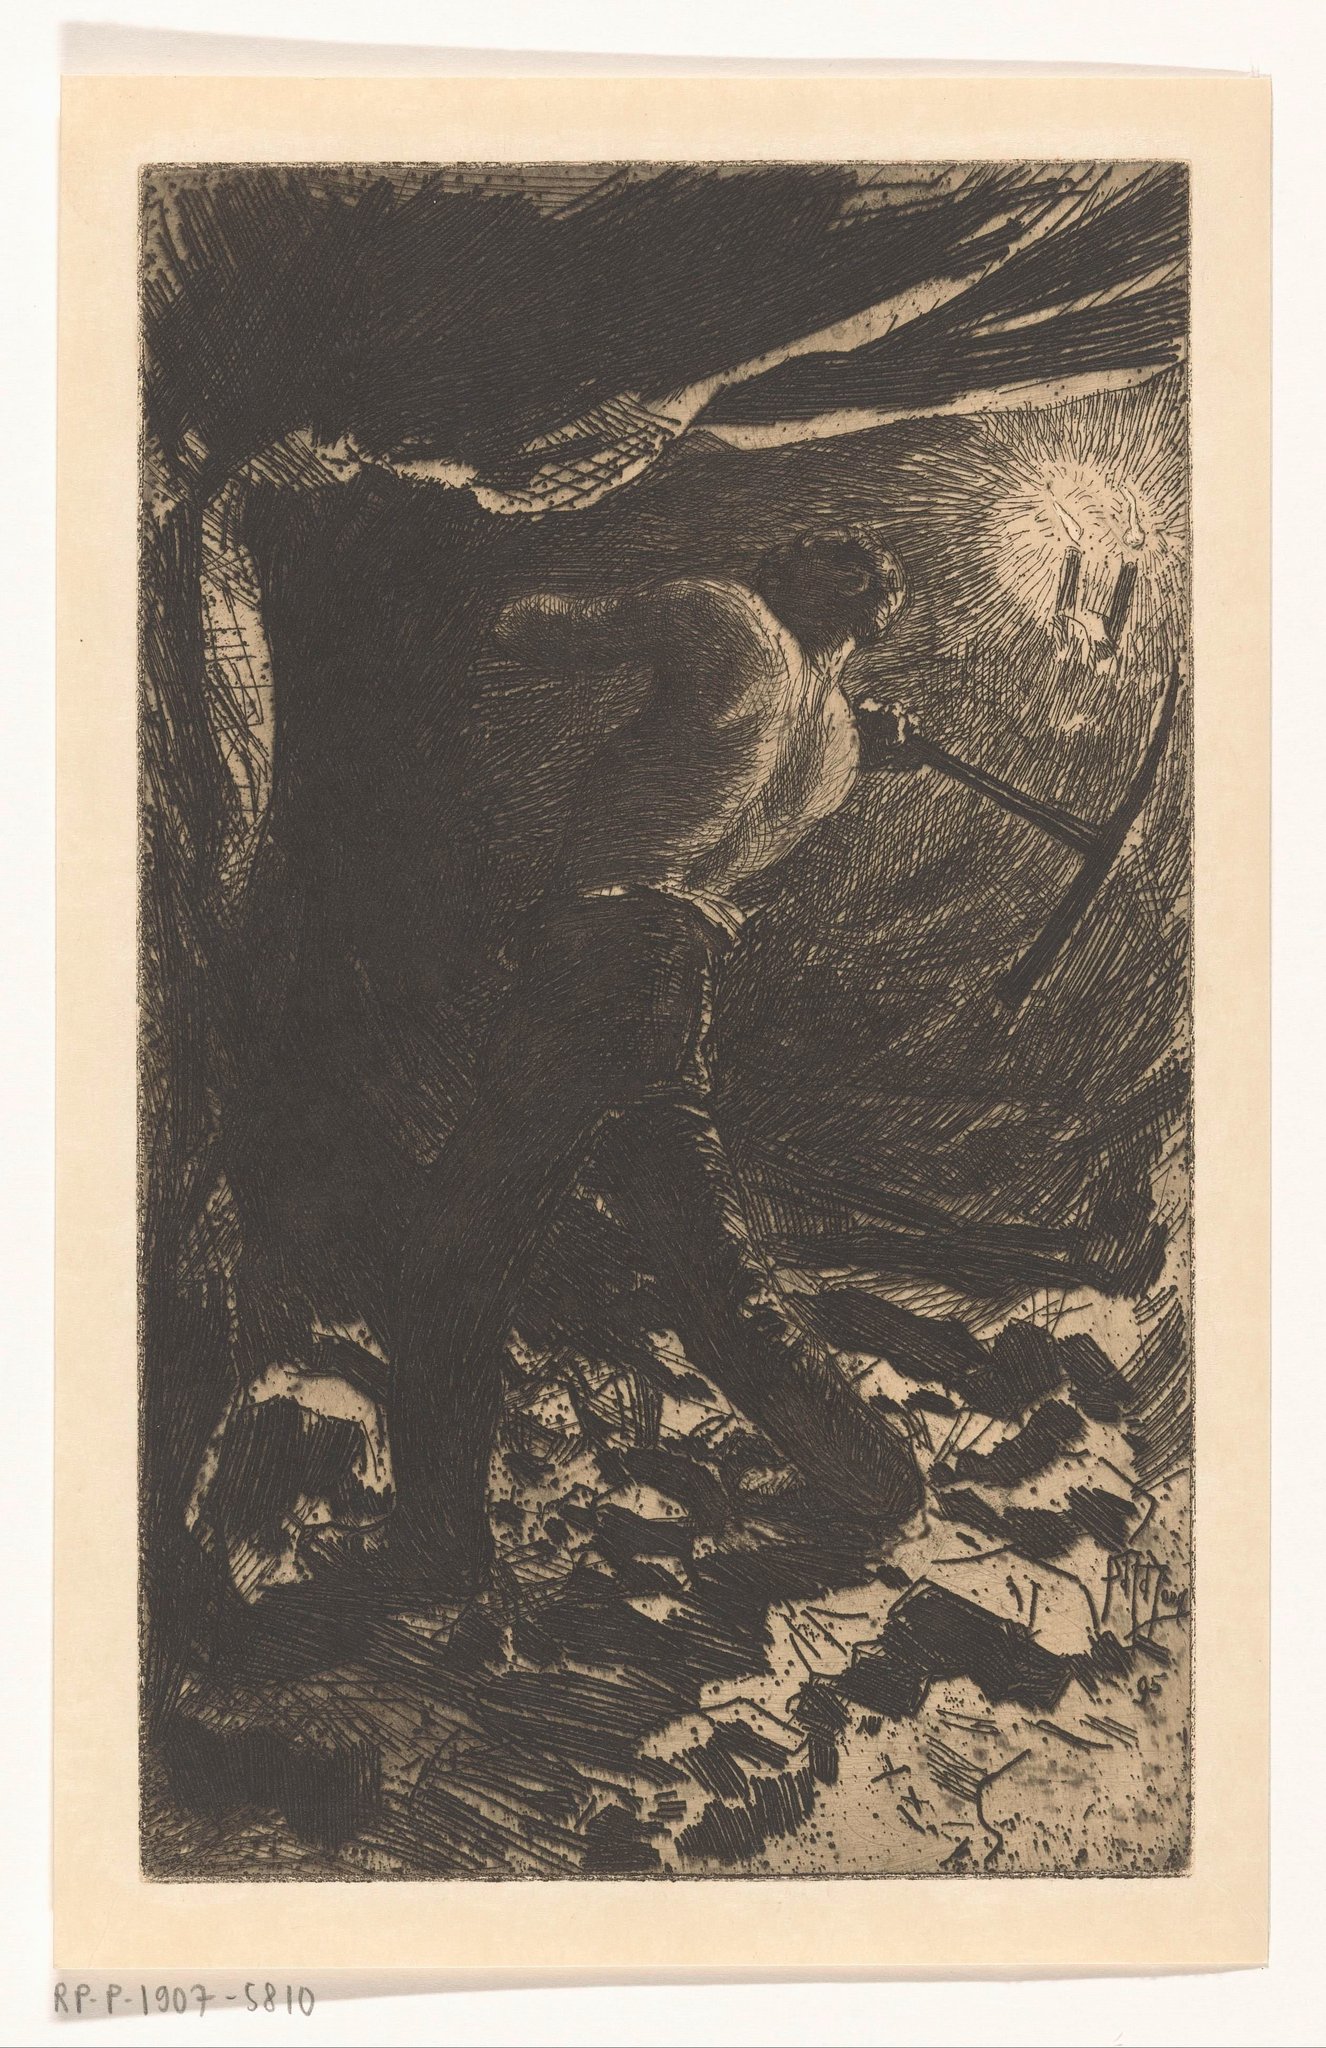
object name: print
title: Mijnarbeider met bloot bovenlijf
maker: pieter de josselin de jong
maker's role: draughtsman, painter, print maker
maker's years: 1861-1906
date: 1895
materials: paper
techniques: etching, intaglio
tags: miner, partially clothed, candle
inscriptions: collector's mark: Lugt 2228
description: De man heeft een pikhouweel in zijn handen. Rechts op de achtergrond twee kaarsen die de mijnschacht verlichten.